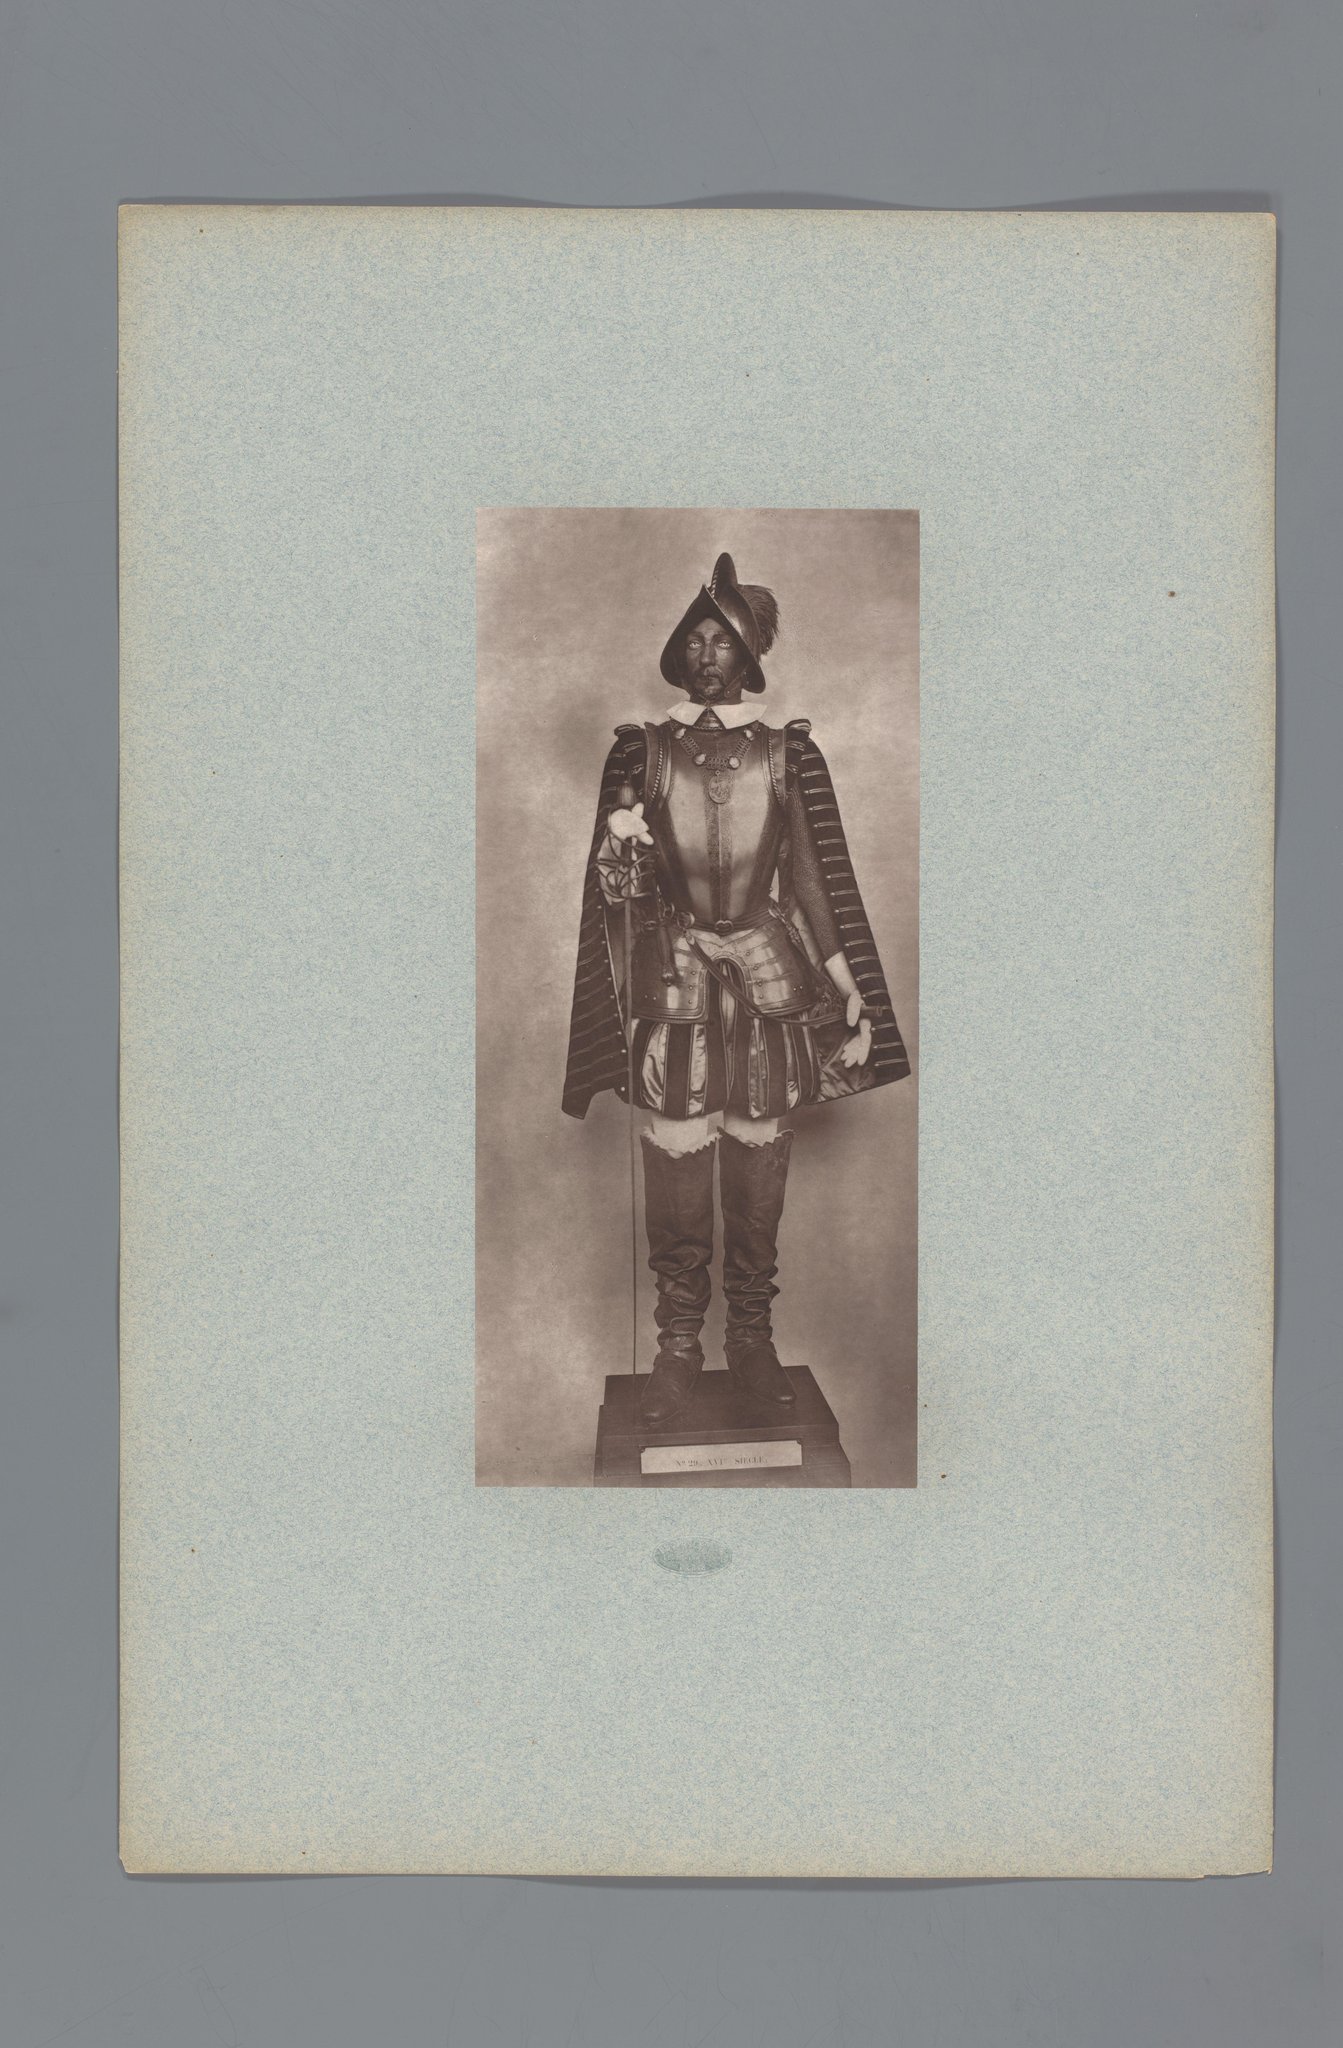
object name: photomechanical print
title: 16de-eeuws harnas met degen uit het leger van Karel IX van Frankrijk, uit de collectie van het Musée d'Artillerie in Parijs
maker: Anonymous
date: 1877-1882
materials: paper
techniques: woodburytype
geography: paris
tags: armour, hacking and thrusting weapons: rapier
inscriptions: check stamp: ‘PHOTOGLYPTIE/ LEMERCIER ET Cie/ PARIS’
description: Deze prent maakt deel uit van een omslag met 36 prenten, een titelblad en een lijst van afbeeldingen.